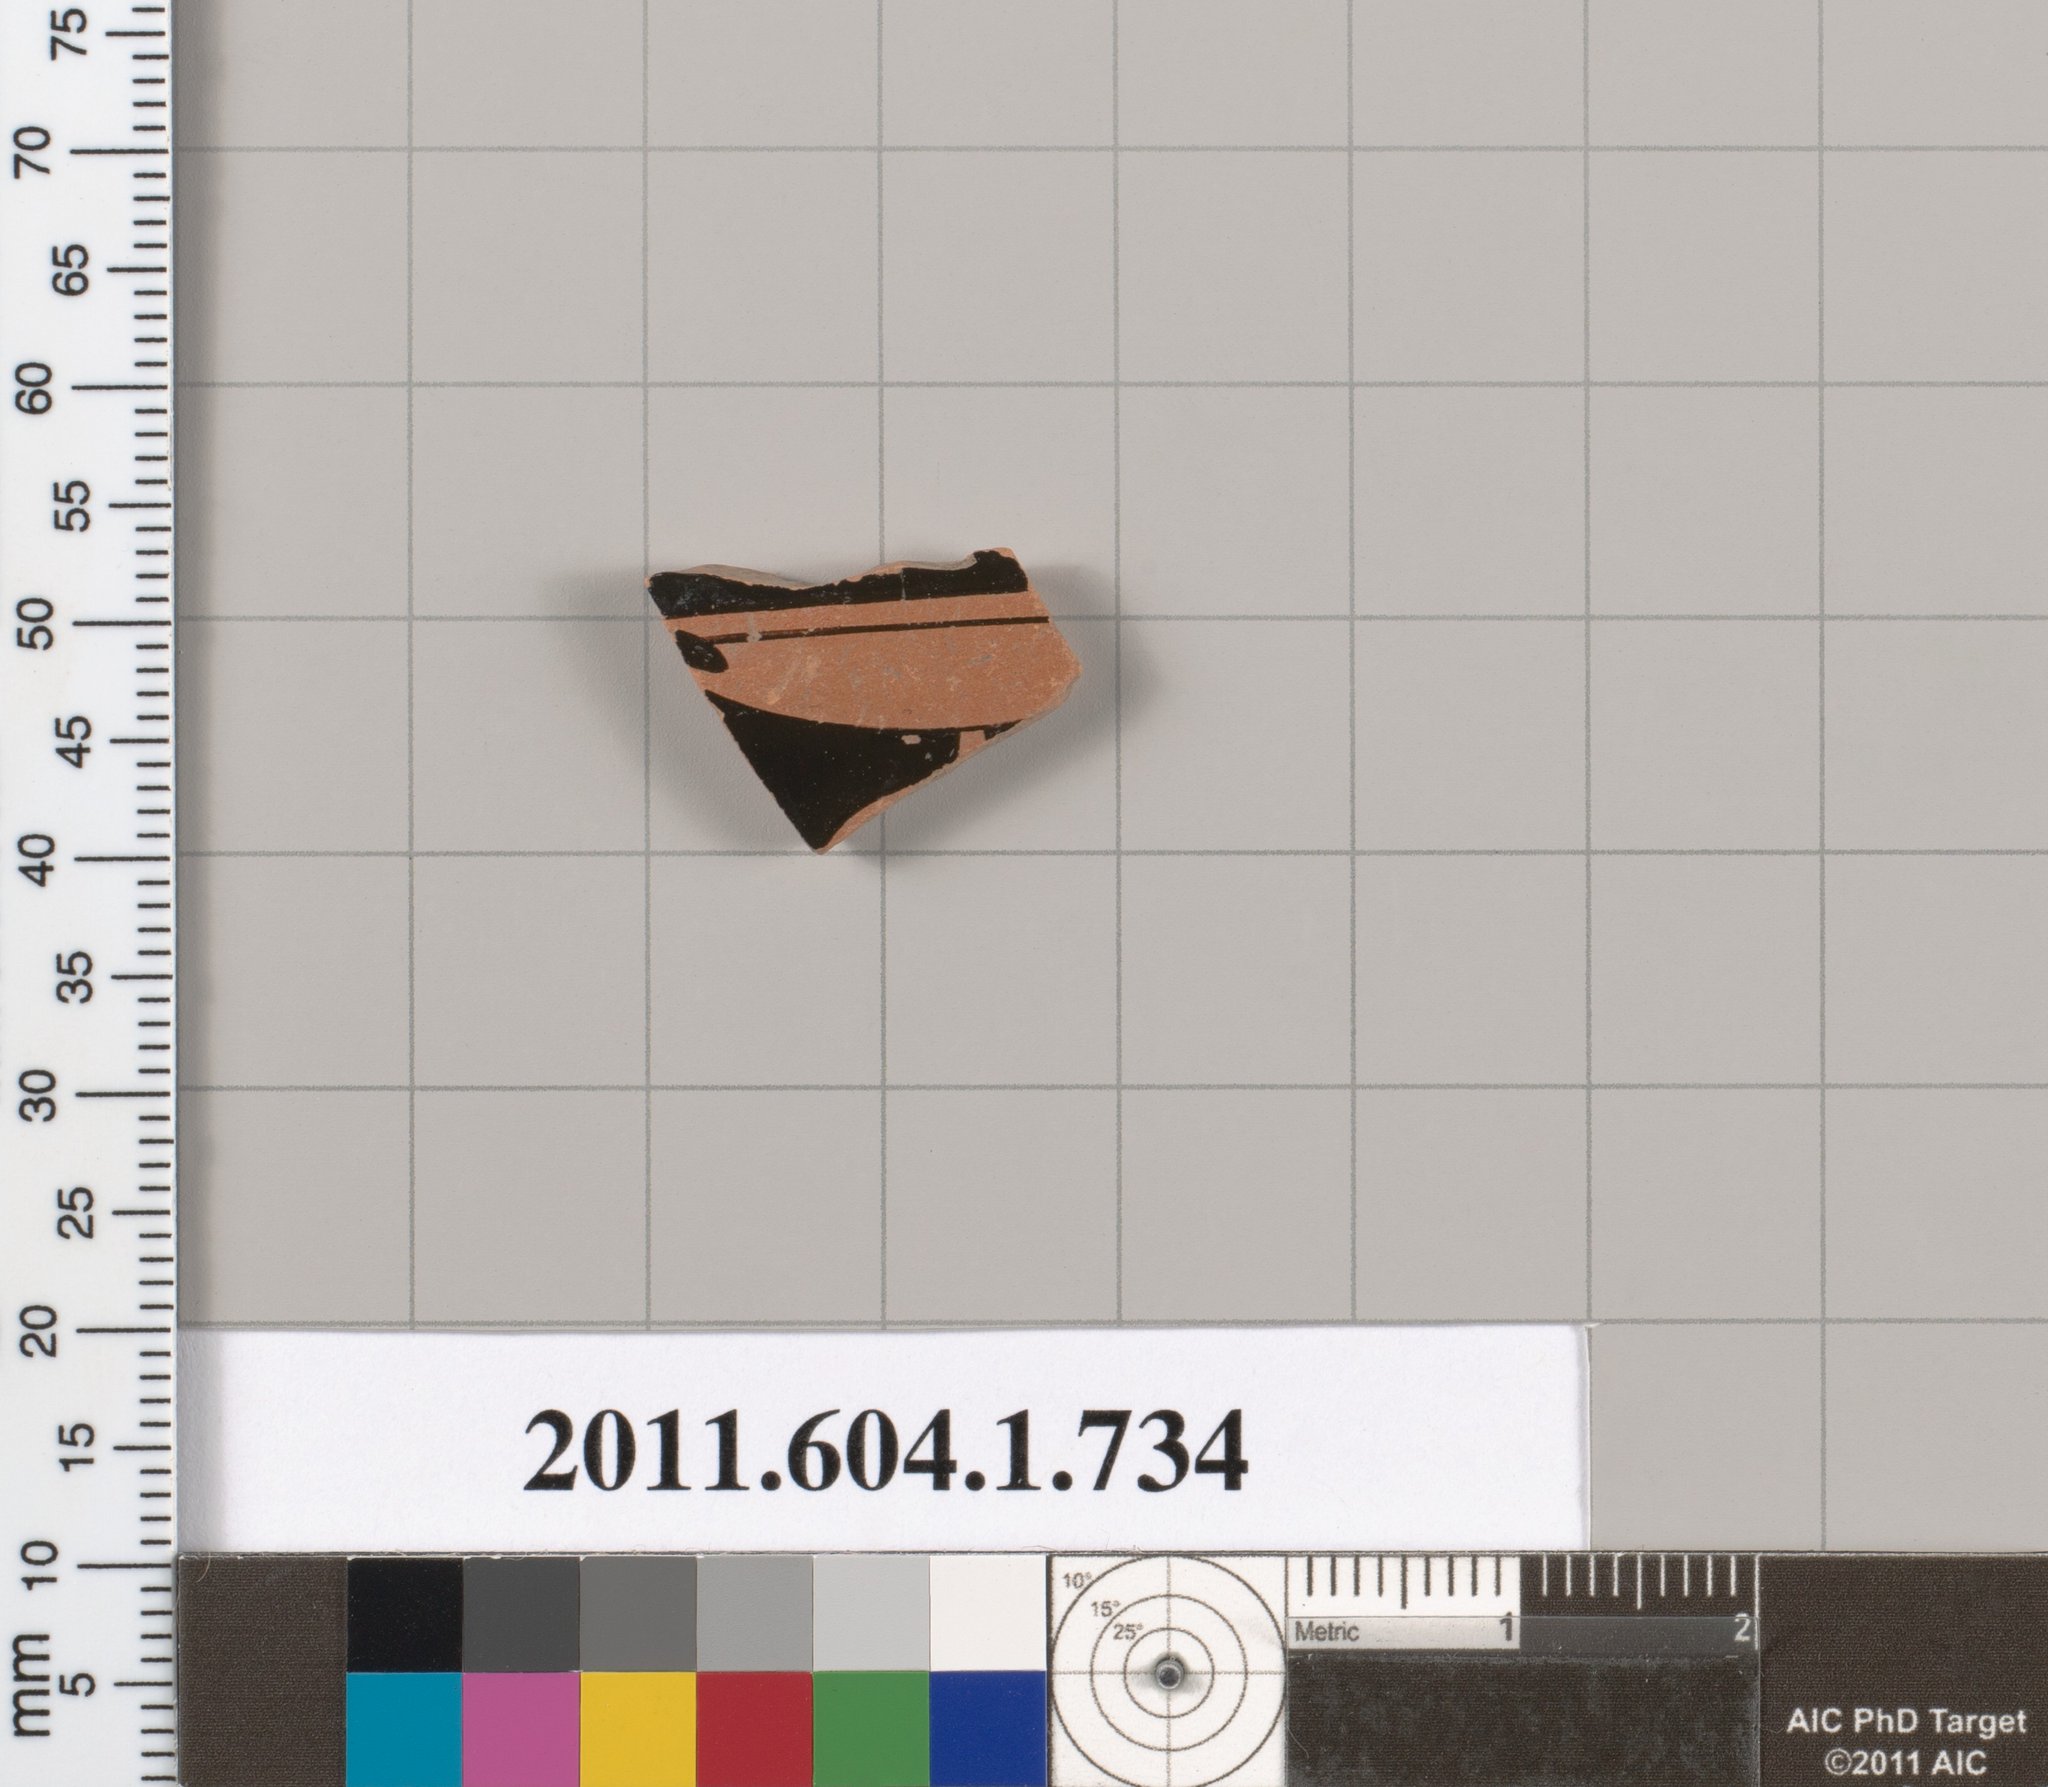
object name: kylix fragment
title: Terracotta fragment of a kylix (drinking cup)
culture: greek, attic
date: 475-451 BCE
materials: terracotta